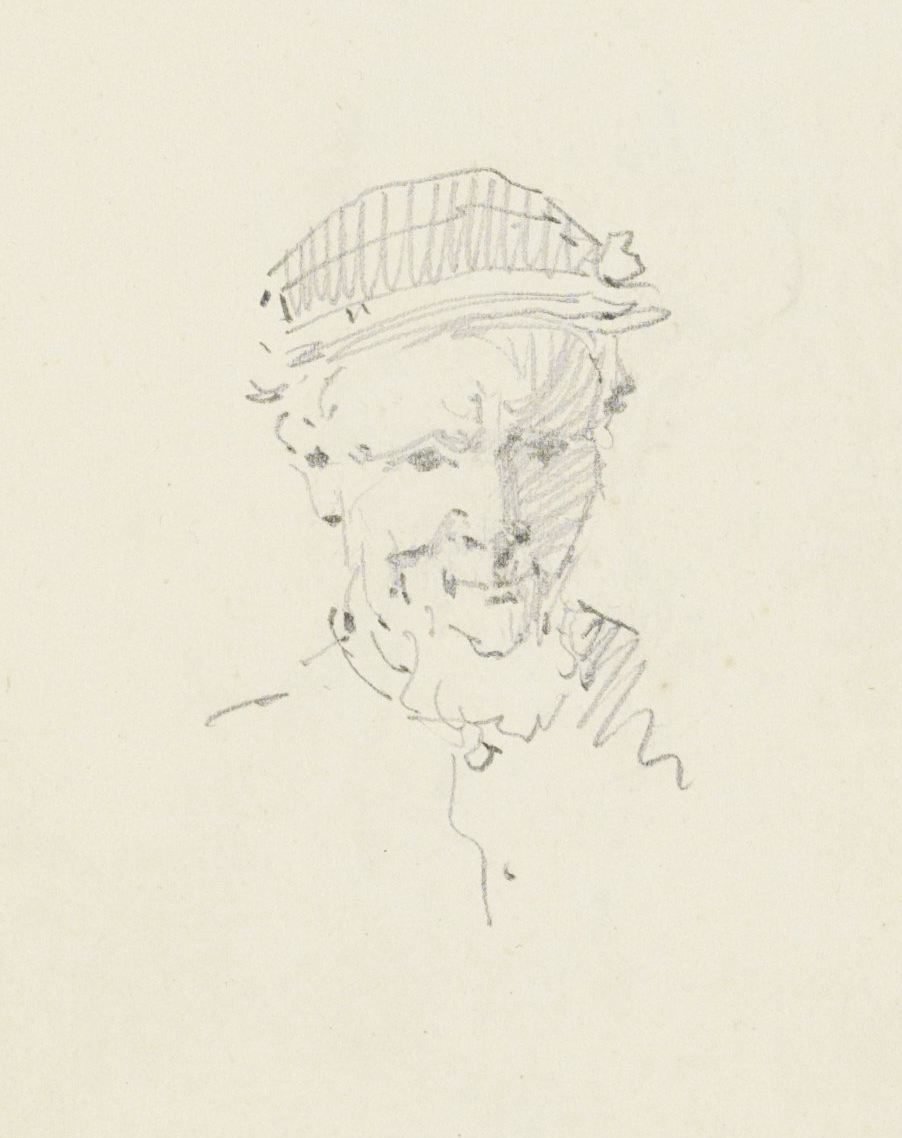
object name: sketchbook leaf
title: Hoofd van een man met een pet en baard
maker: alfred william rich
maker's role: draughtsman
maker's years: 1856-1921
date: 1892-1893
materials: paper, pencil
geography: zaandam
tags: head (human), head-gear: cap (+ men's clothes), beard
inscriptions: annotation: ‘Zamdaam[sic] Steamer’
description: Reiziger getekend op de stoomboot naar Zaandam. Blad 7 recto uit een schetsboek met 86 bladen.